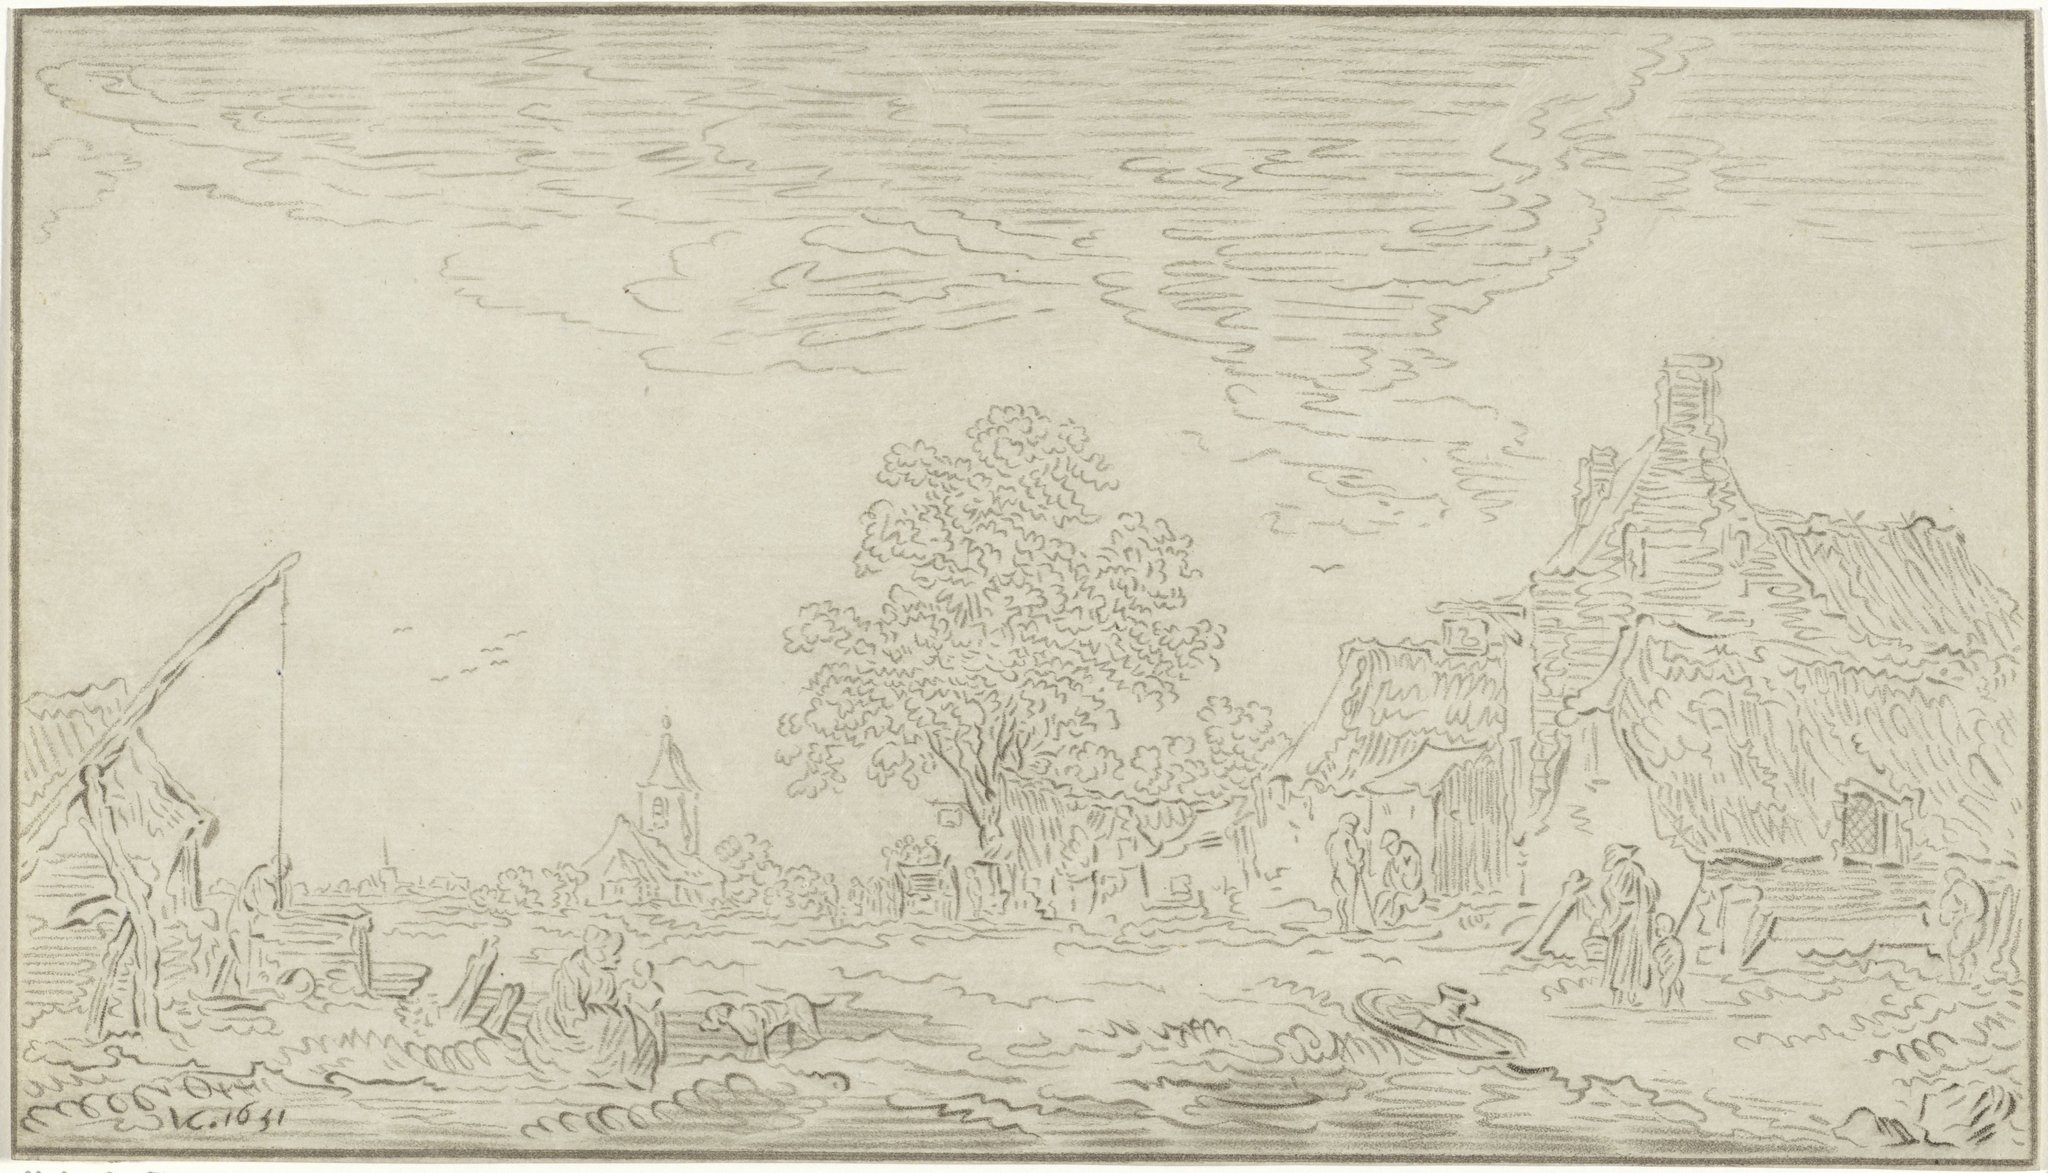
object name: print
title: Gezicht op een dorp met links een waterput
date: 1767-1780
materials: paper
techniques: printmaking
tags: village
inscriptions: collector's mark: Lugt 240